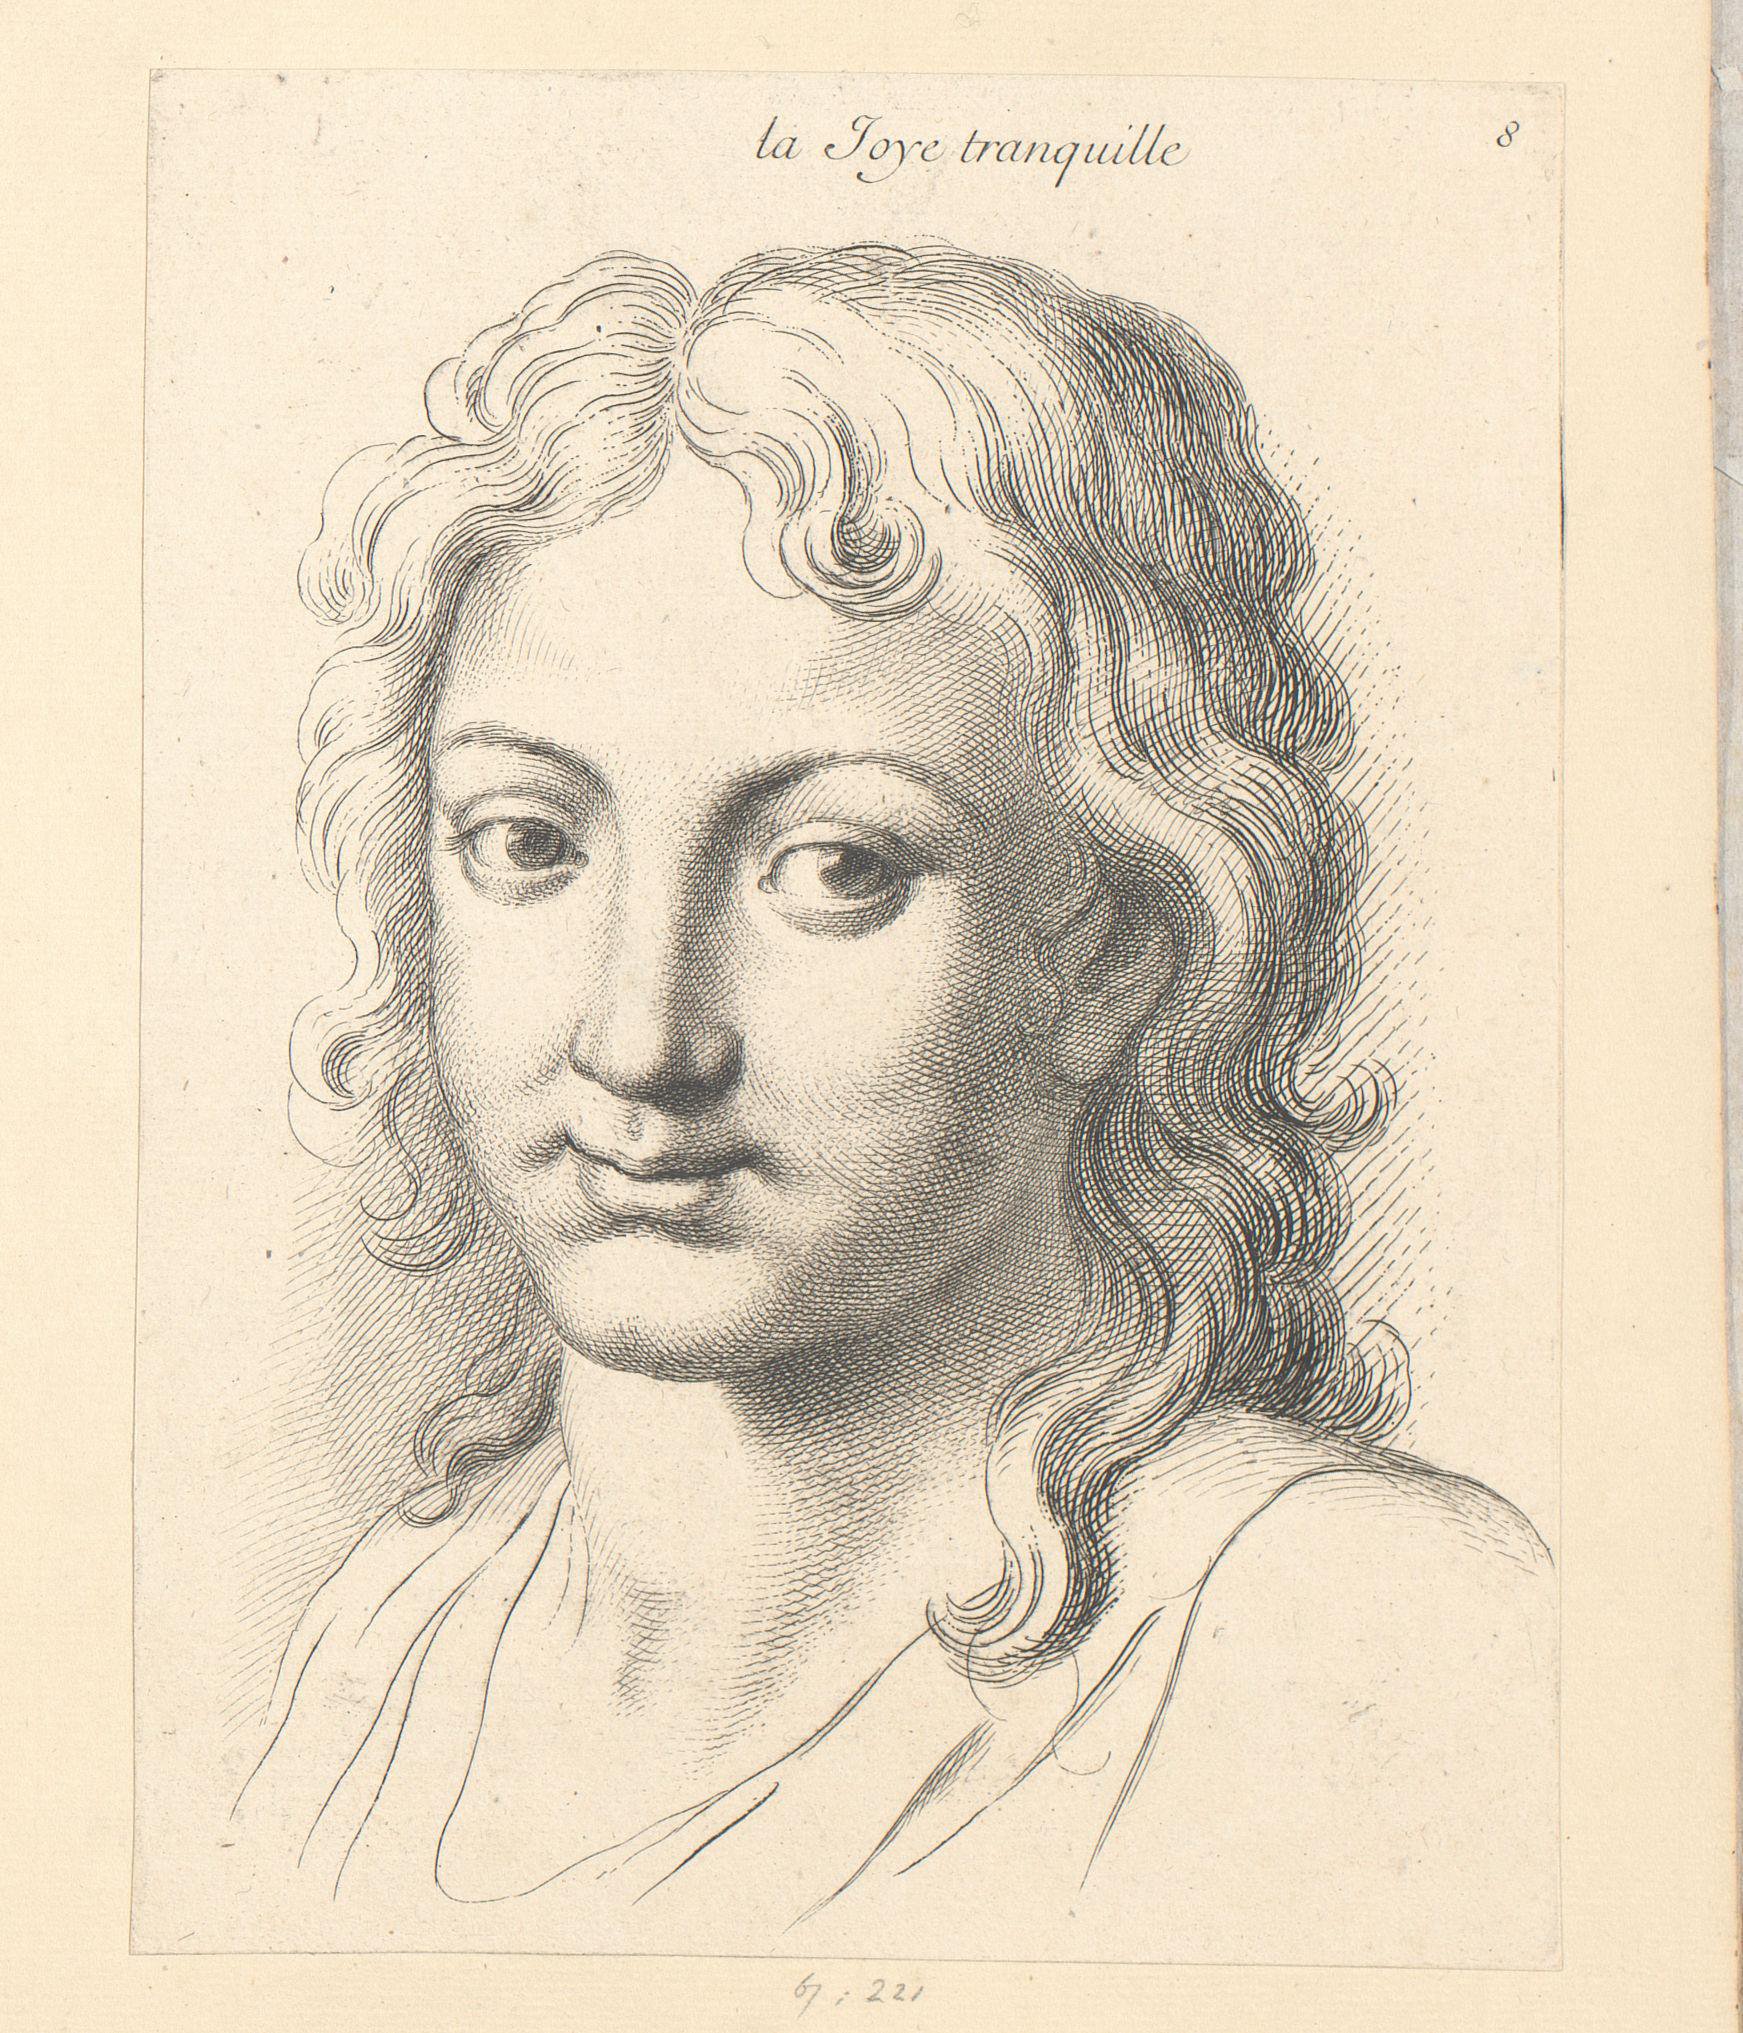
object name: album leaf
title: Werken van Charles le Brun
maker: jean audran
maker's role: print maker, publisher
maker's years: 1667-1756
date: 1727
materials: paper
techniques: engraving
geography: paris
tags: face, pleasure, enjoyment, joy; 'allegrezza', 'allegrezza da le medaglie', 'allegrezza, letitia e giubilo', 'diletto', 'piacere', 'piacere honesto' (ripa), confidence, security, tranquillity; 'confidenza', 'sicurezza e tranquillità', 'sicurtà', 'sicurtà o sicurezza', 'tranquillità' (ripa), morphology of facial expression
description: Prent uit: Le Brun, Charles. Expressions des Passions de l'Ame. Representées en plusieurs testes gravées d'apres les desseins de feu Monsieur le Brun, Premier Peintre du Roy. Parijs: Jean Audran, 1727. Reeks van 19 portretten, een titelprent en twee (dubbelzijdig bedrukte) bladen tekst.